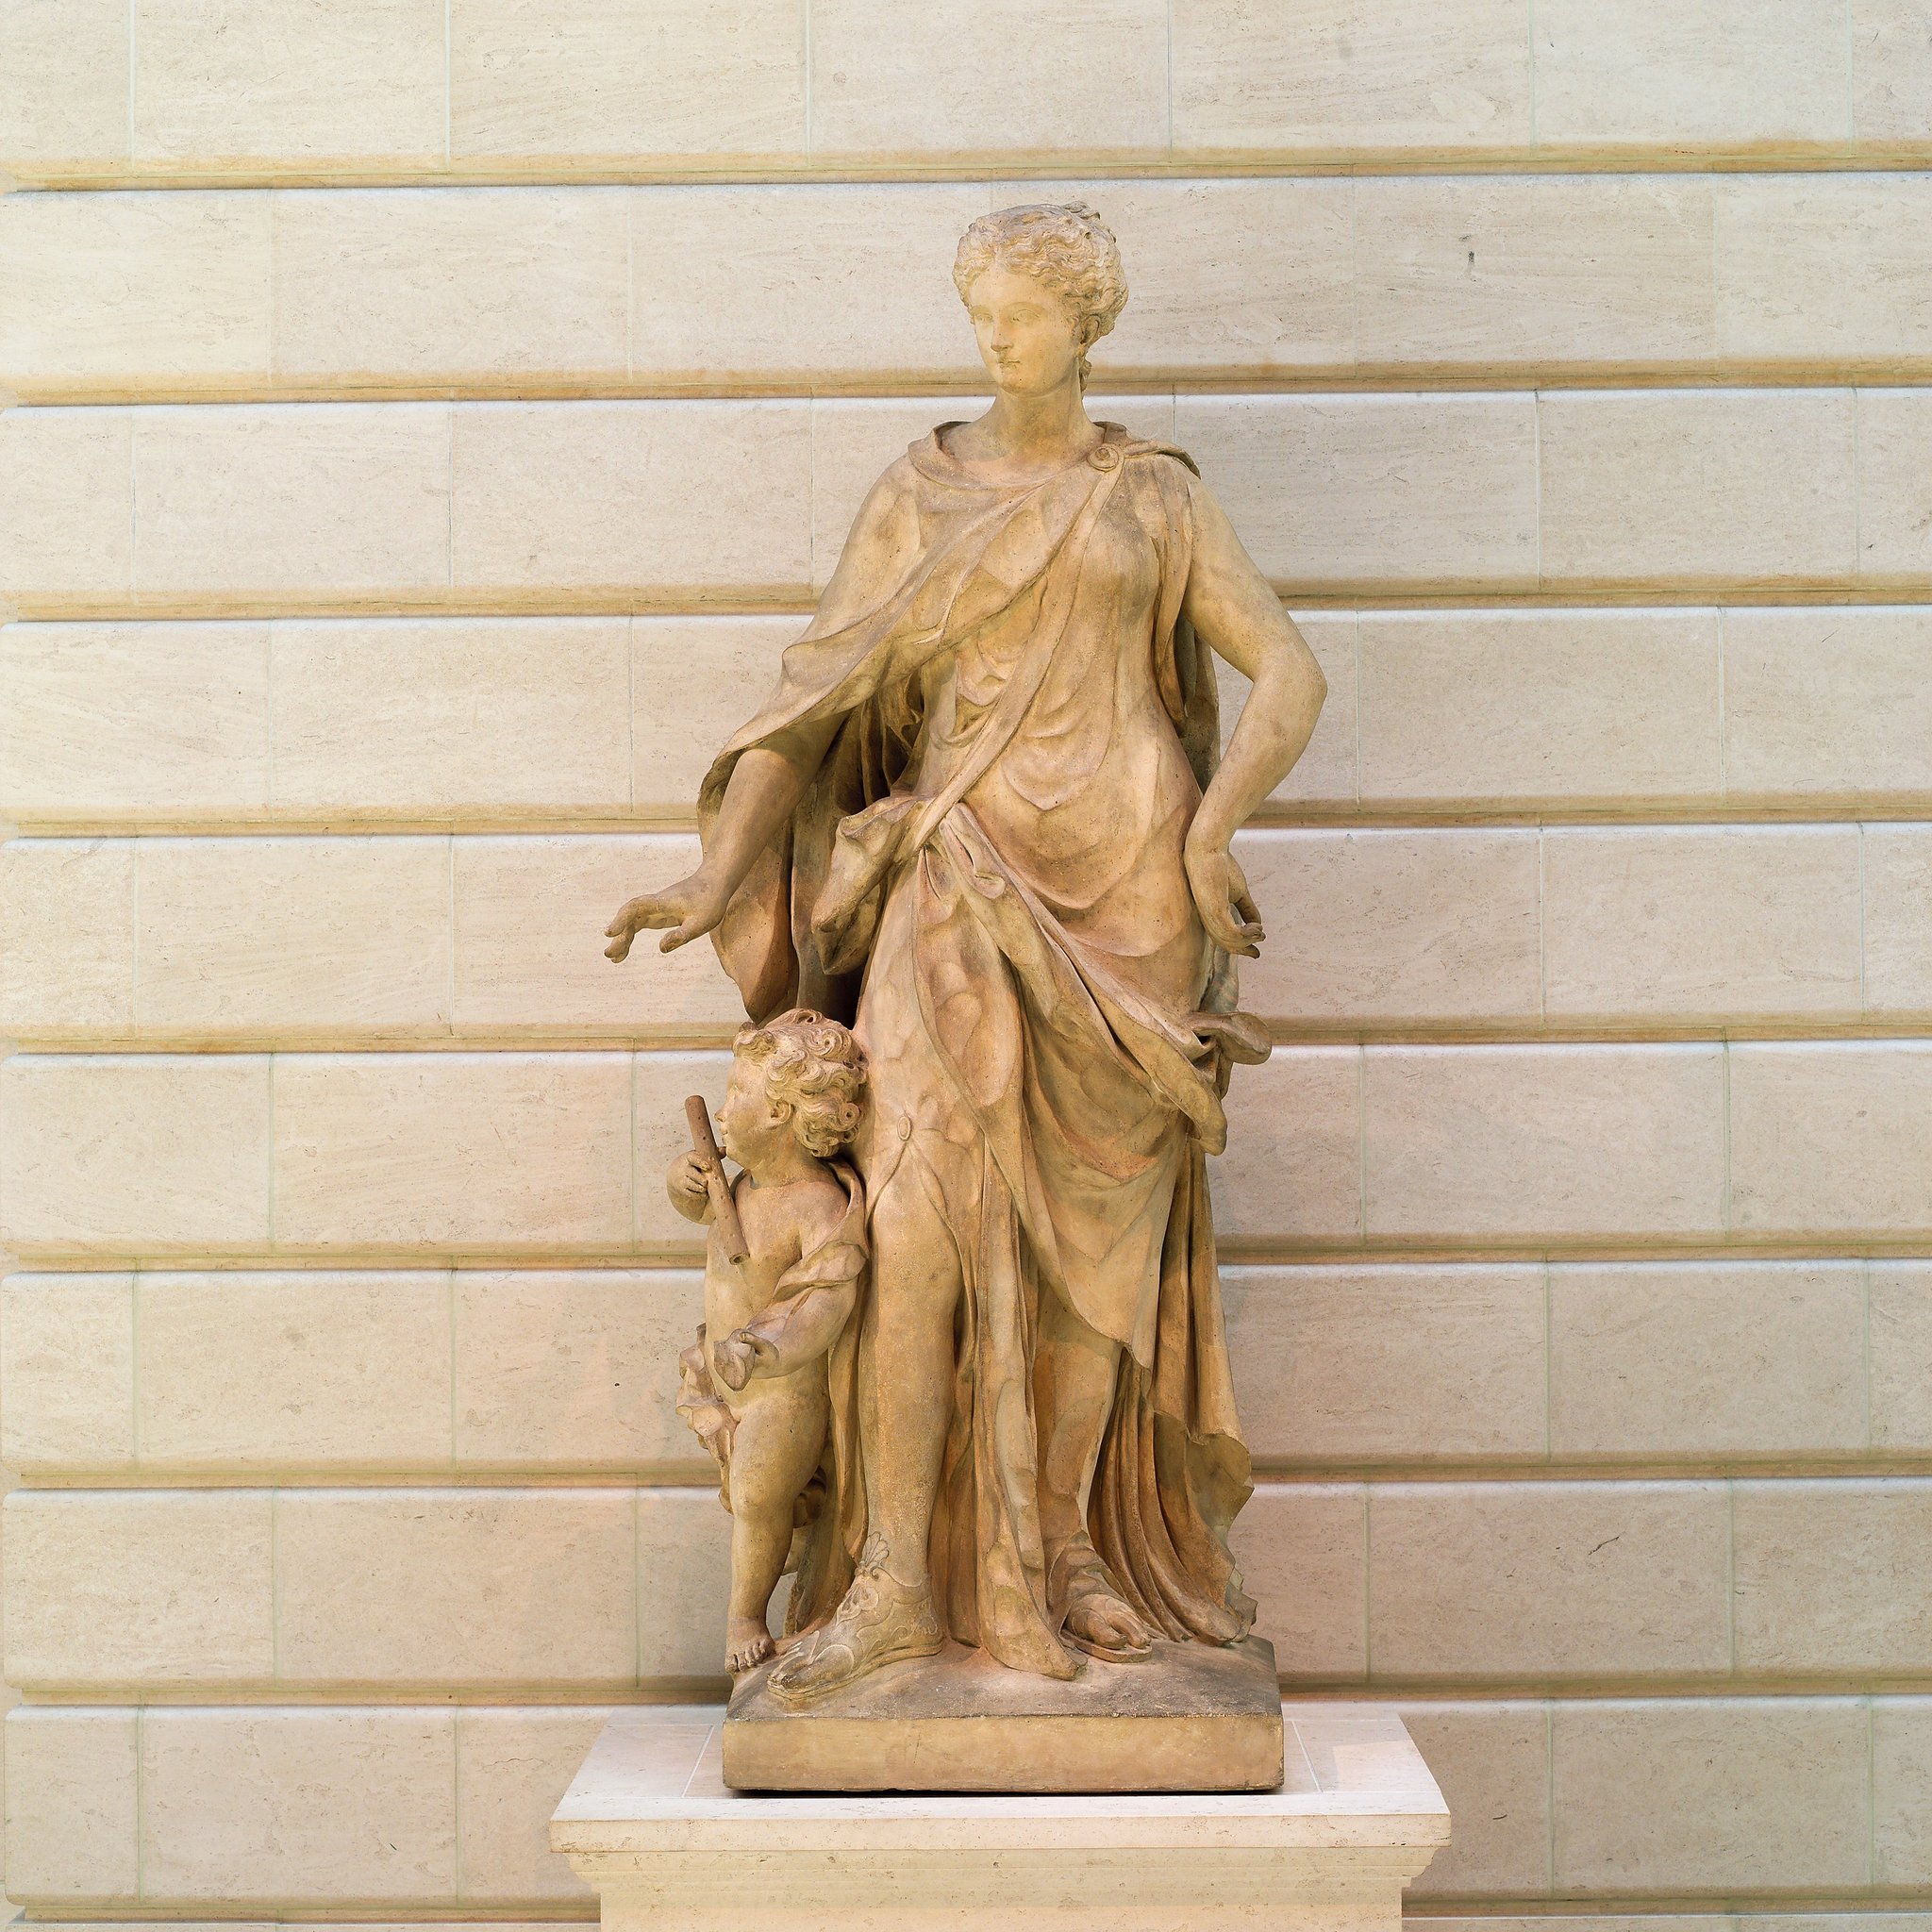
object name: statue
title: Air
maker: jean-pierre defrance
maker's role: artist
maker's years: 1694-1768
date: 1750-1760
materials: limestone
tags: women,putti